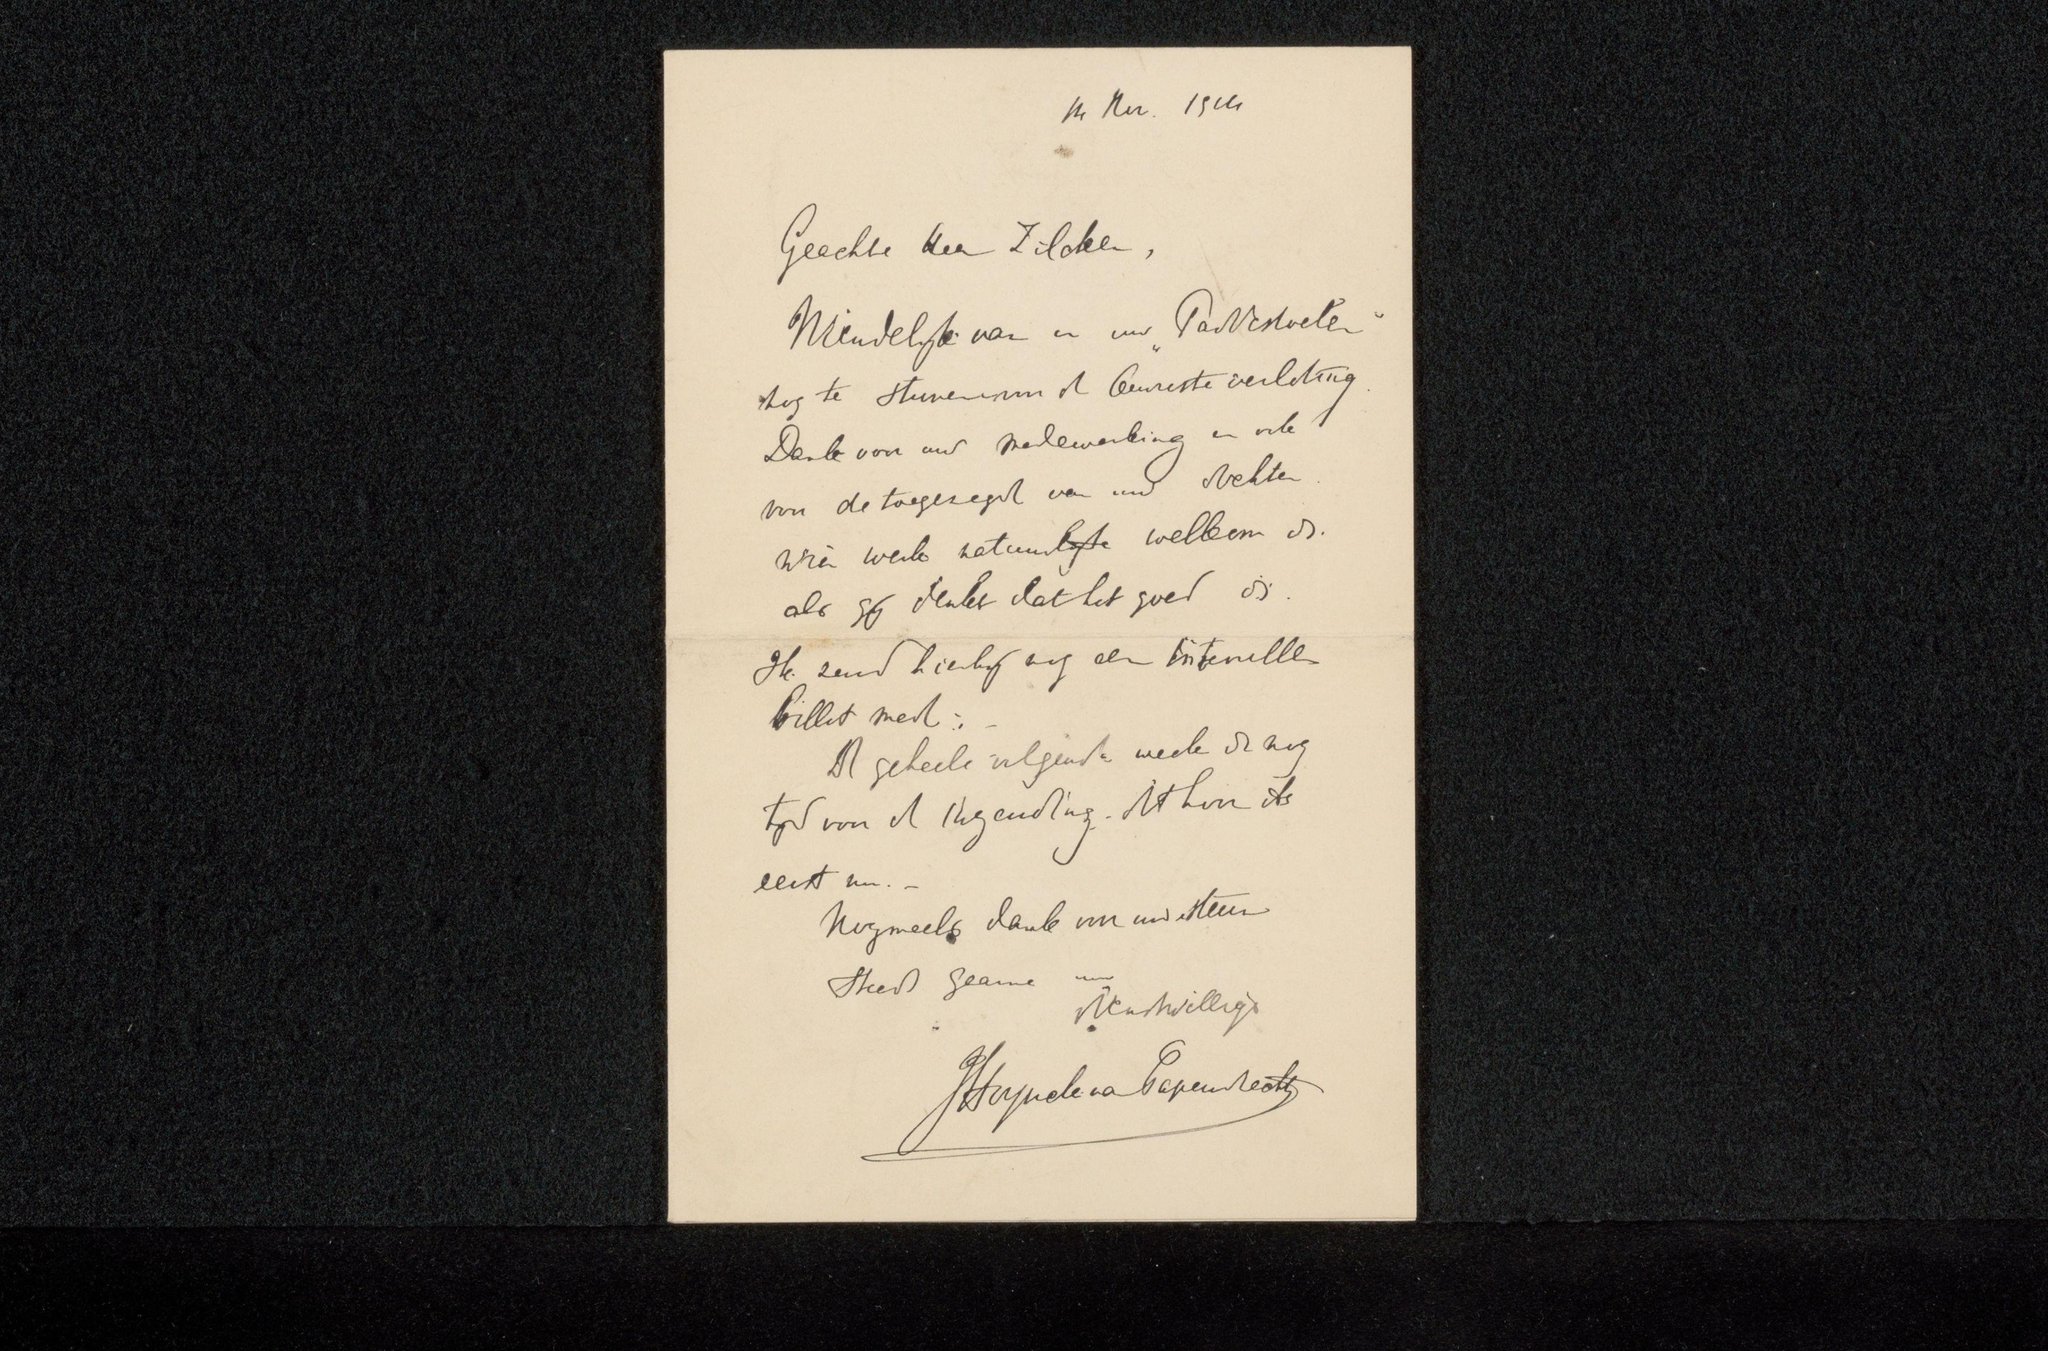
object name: letter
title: Brief aan Philip Zilcken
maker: jan hoynck van papendrecht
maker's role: draughtsman, painter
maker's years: 1858-1933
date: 1914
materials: ink, paper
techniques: pen, writing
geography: the hague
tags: philip zilcken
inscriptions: collector's mark: ‘RPK’